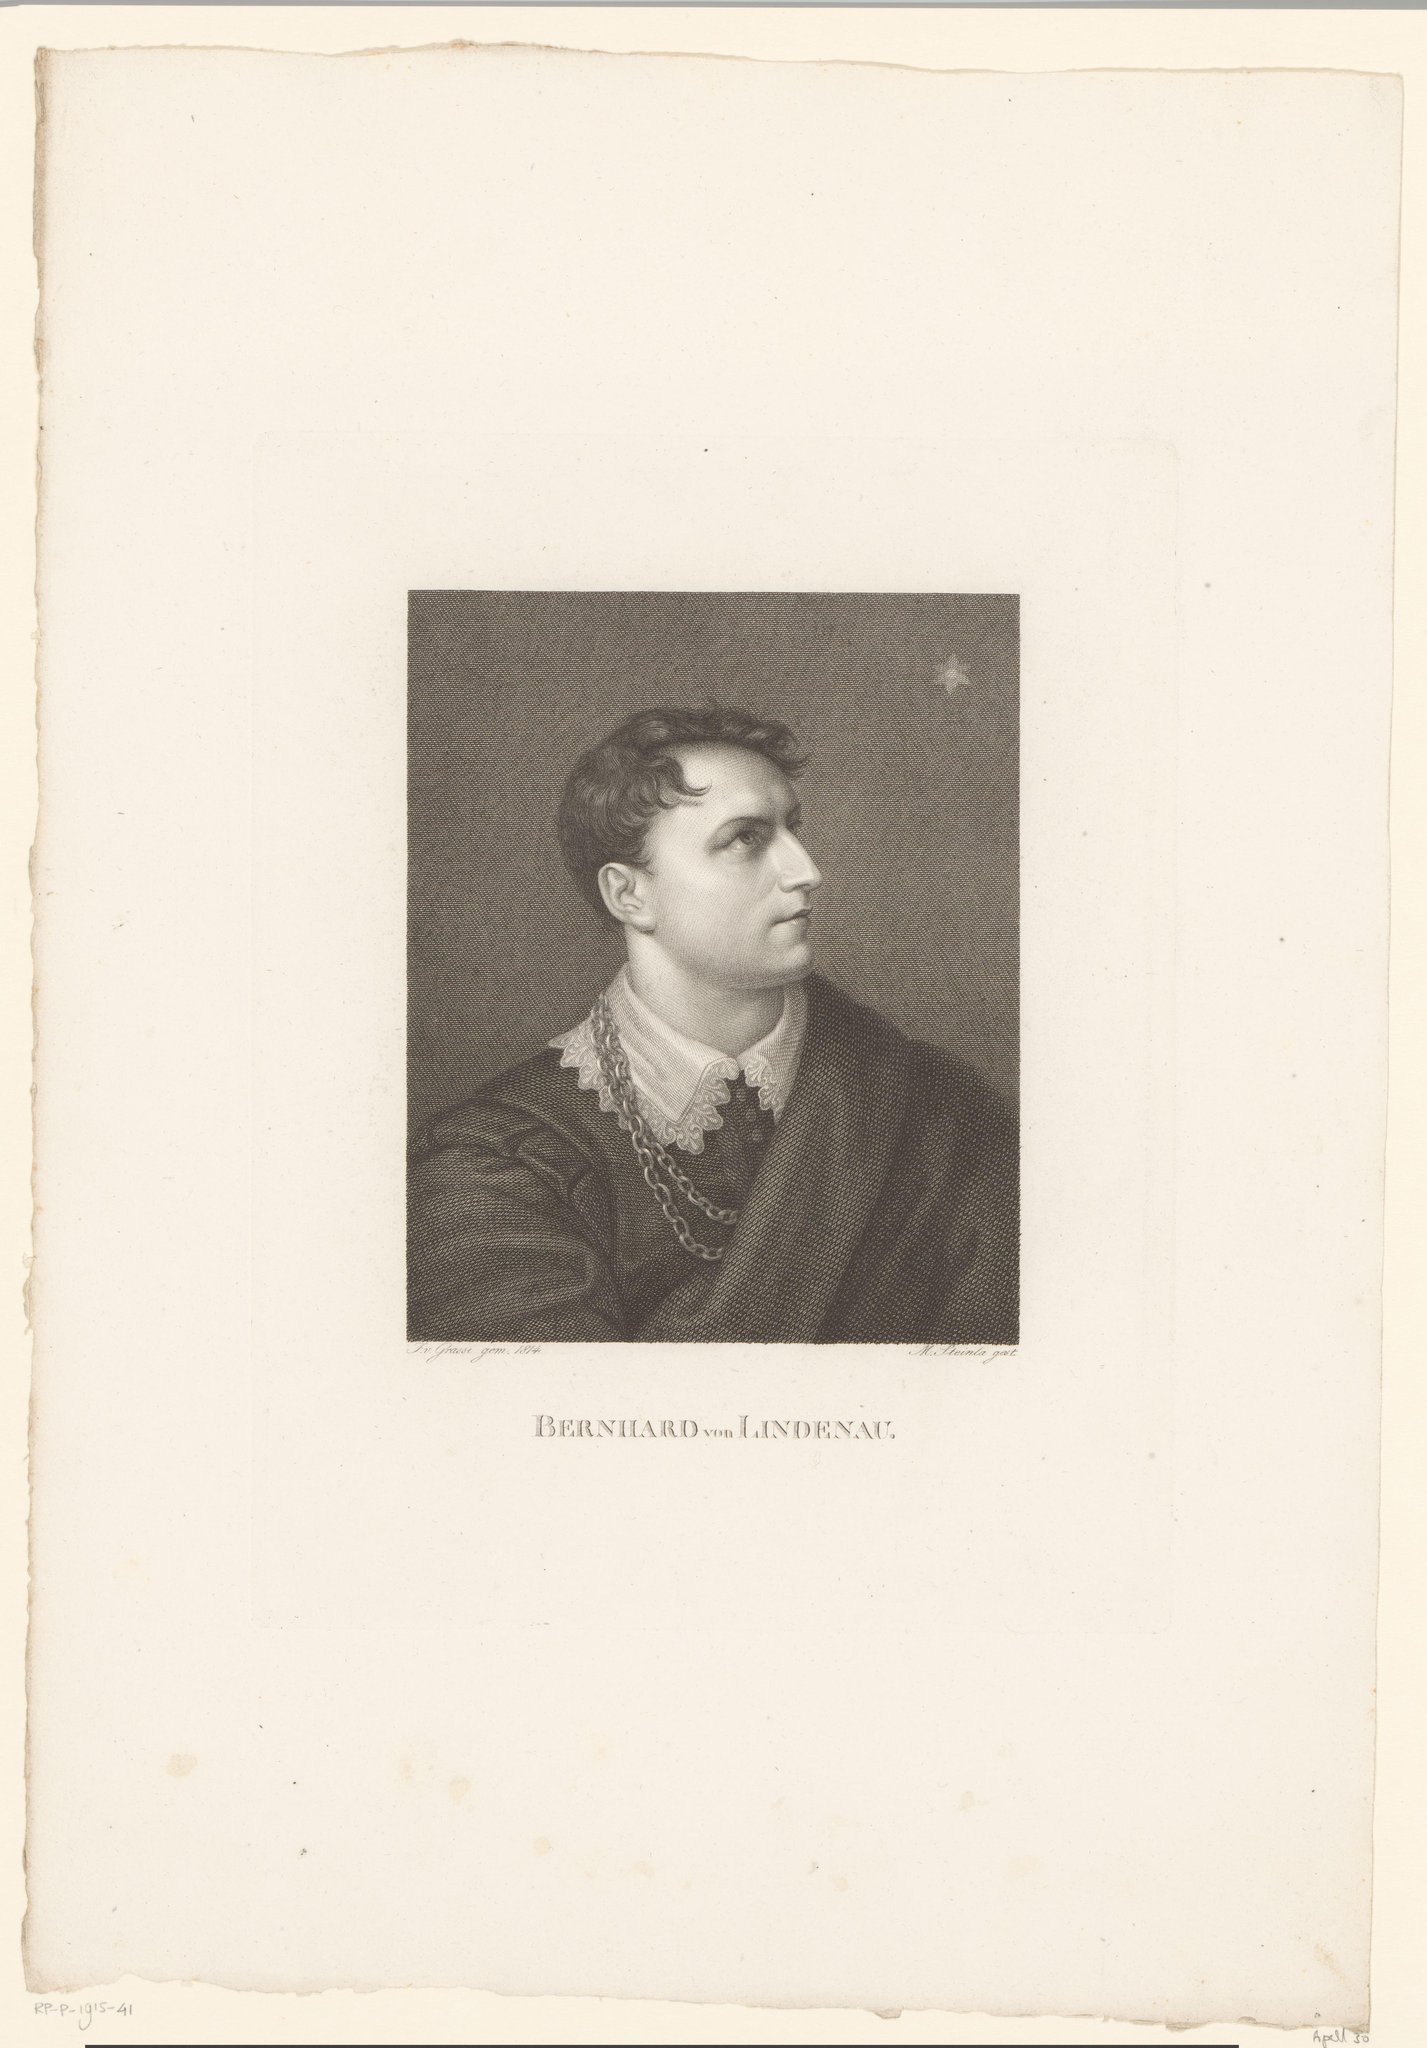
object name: print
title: Portret van Bernhard von Lindenau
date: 1814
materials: paper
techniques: engraving, etching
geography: germany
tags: historical persons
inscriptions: collector's mark: Lugt 2228